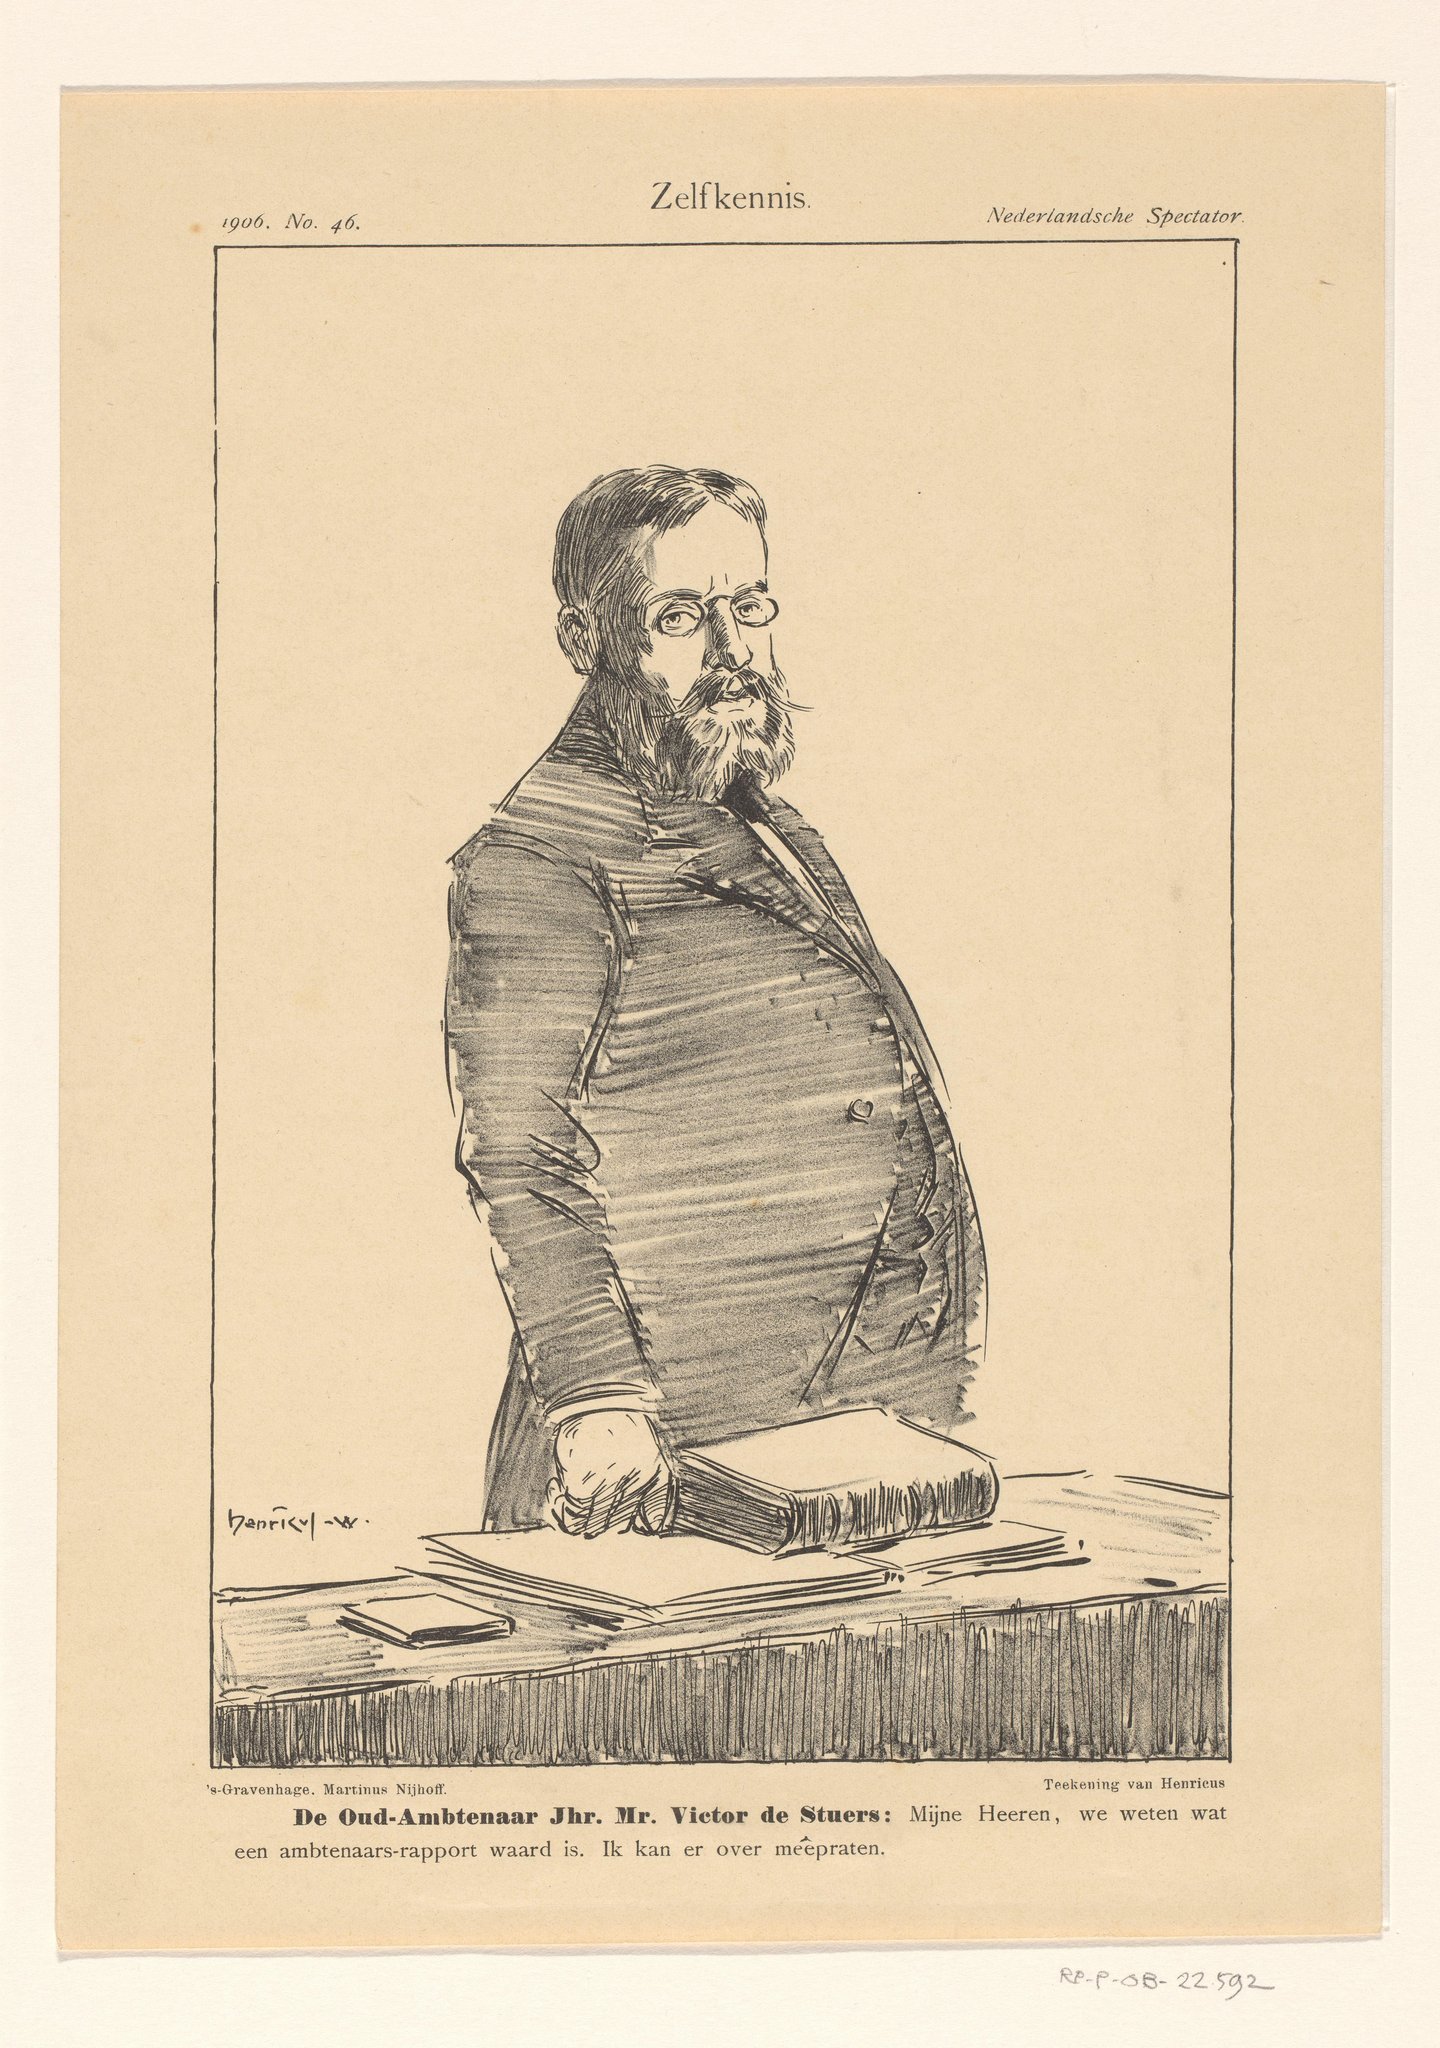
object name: print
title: Zelfkennis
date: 1906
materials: paper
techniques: lithograph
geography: the hague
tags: maastricht, the hague, print maker, draughtsman, jonkheer victor eugène louis de stuers, historical persons, political caricatures and satires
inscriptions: collector's mark: Lugt 2228a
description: Spotprent verschenen in: De Nederlandsche Spectator (1906), no. 46.